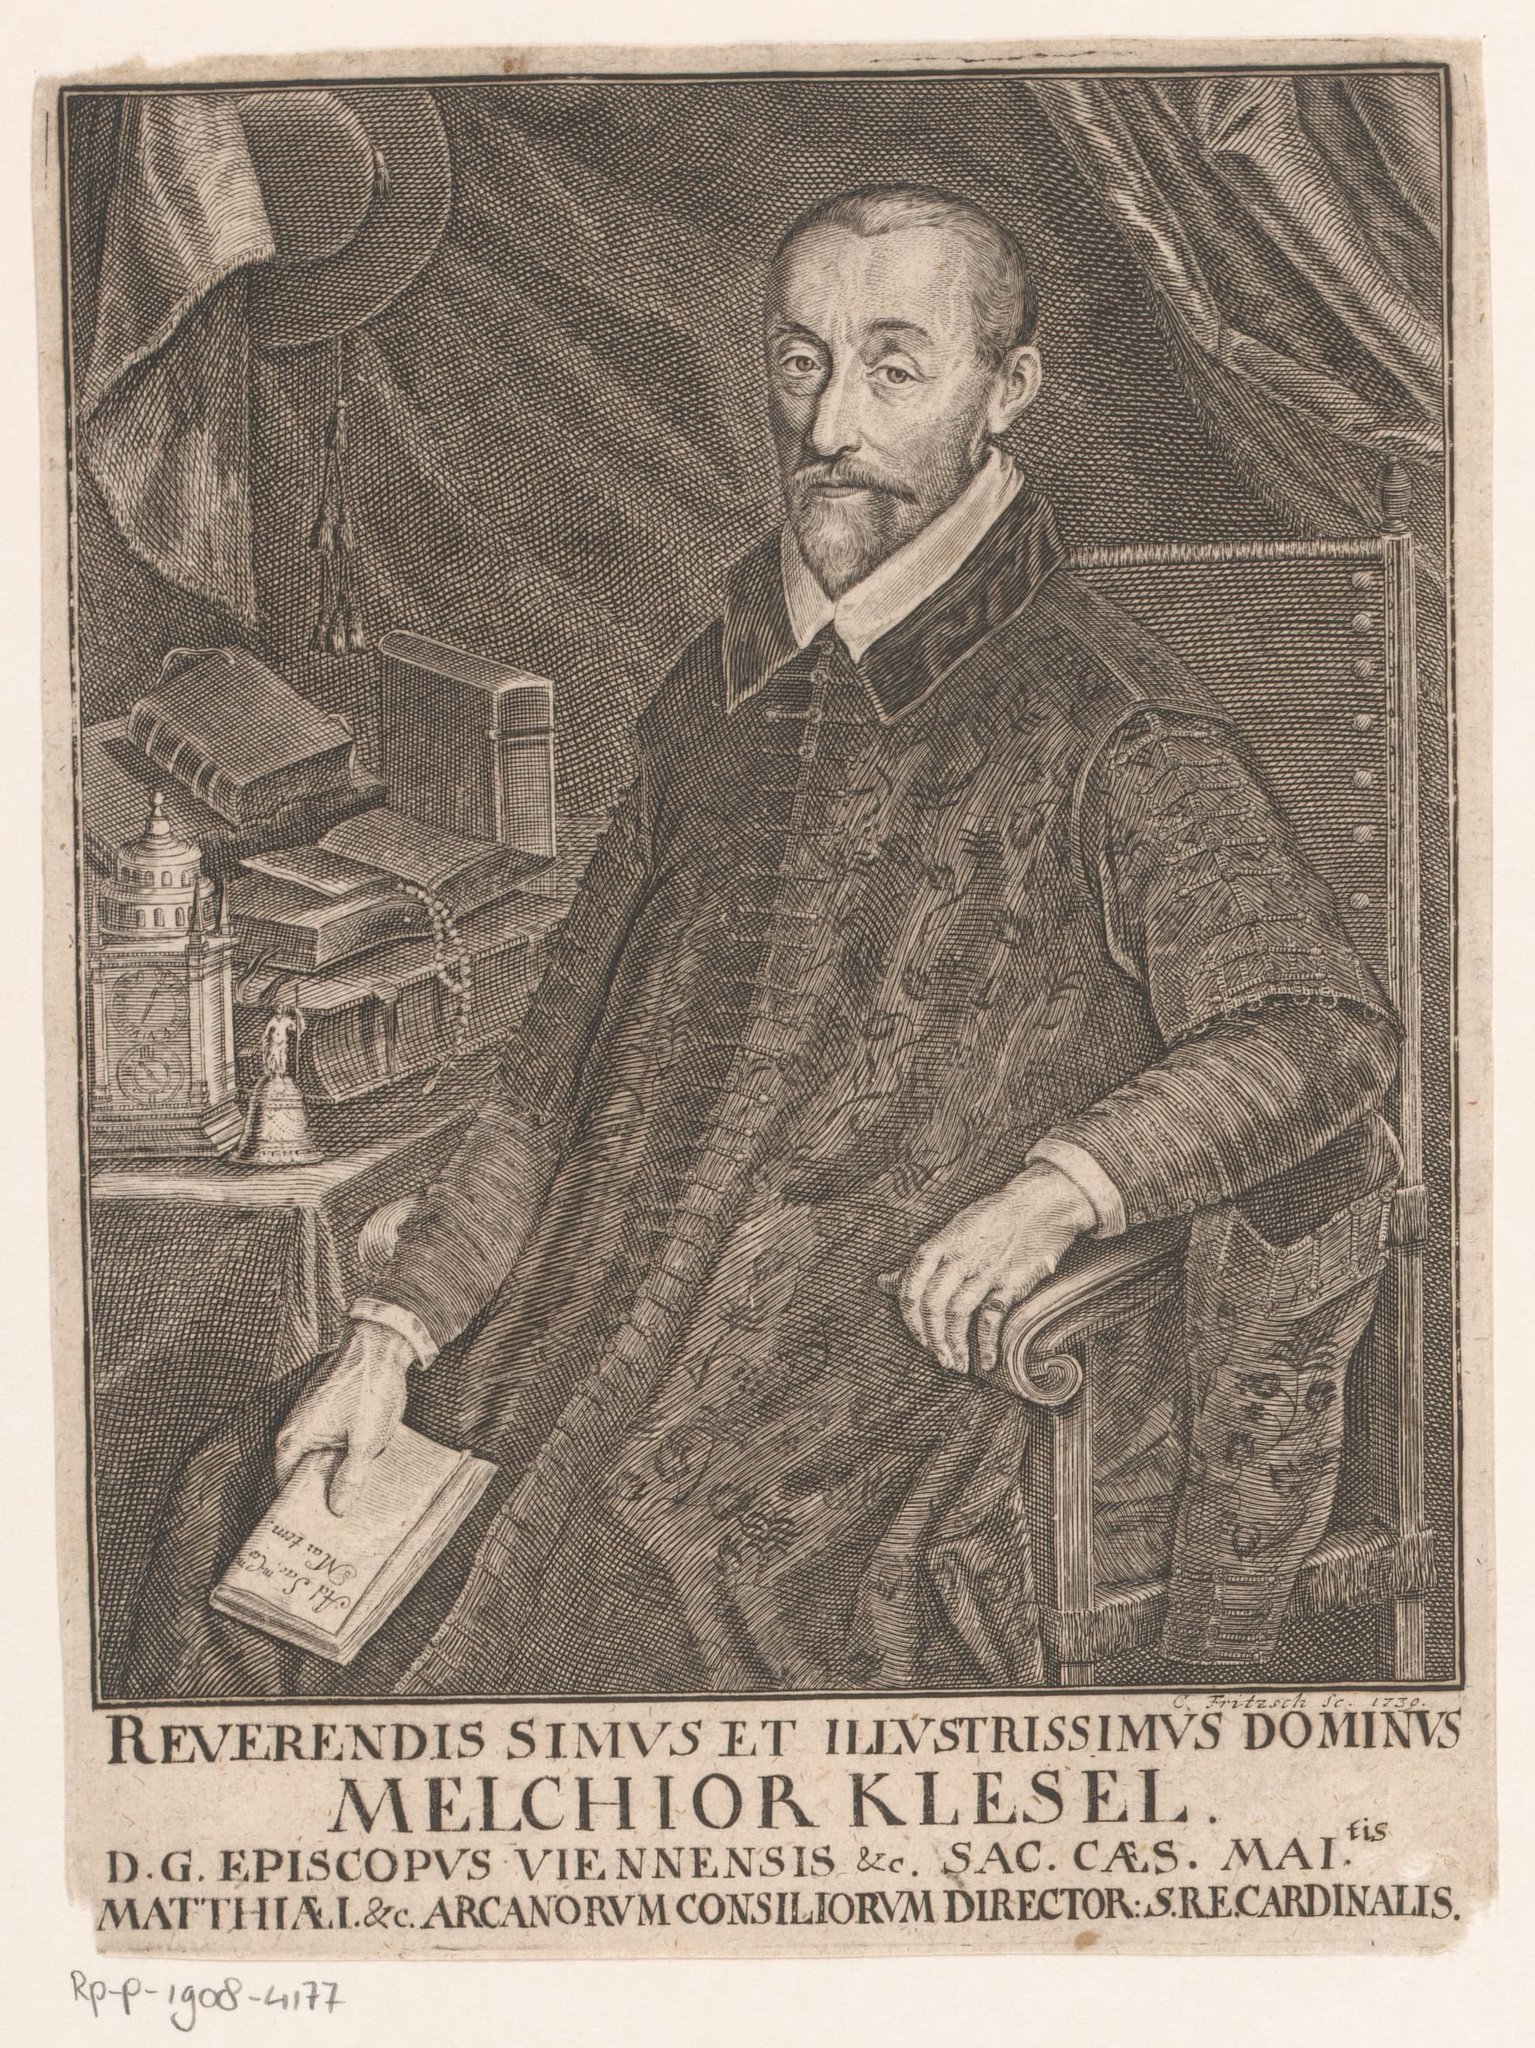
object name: print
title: Portret van Melchior Klesel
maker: christian fritzsch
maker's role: print maker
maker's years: 1695-1769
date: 1739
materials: paper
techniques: engraving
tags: vienna, bell ~ musical instruments, historical persons, head-gear: hat, book, clock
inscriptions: collector's mark: Lugt 2228